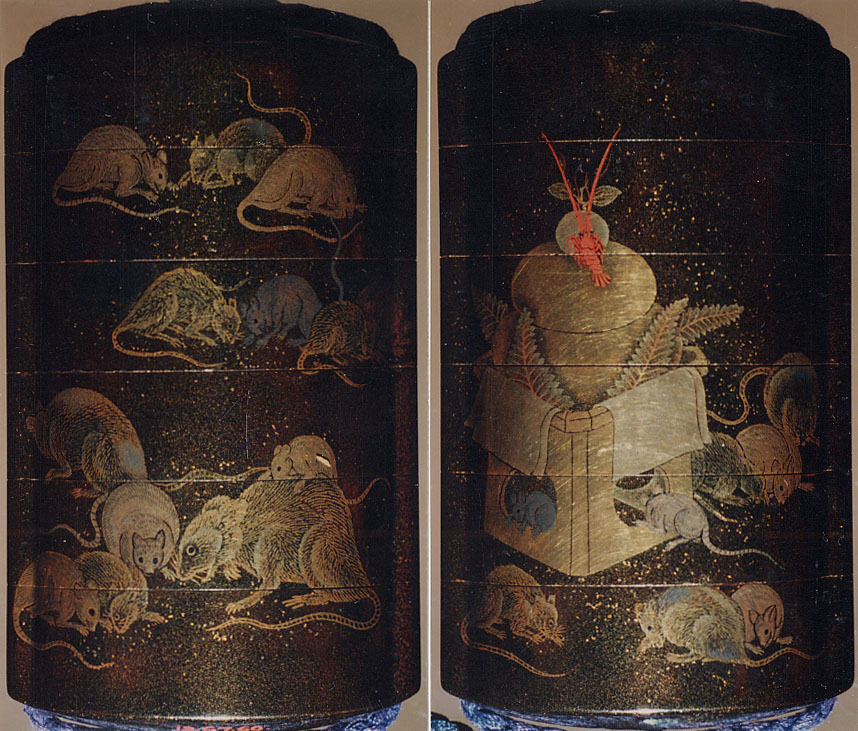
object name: inrō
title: Case (Inrō) with Design of Rats Eating Rice beside New Year Arrangement with Mochi and Crayfish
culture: japanese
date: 1801-1900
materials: gold, lacquer, silver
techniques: fundame, roiro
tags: rats